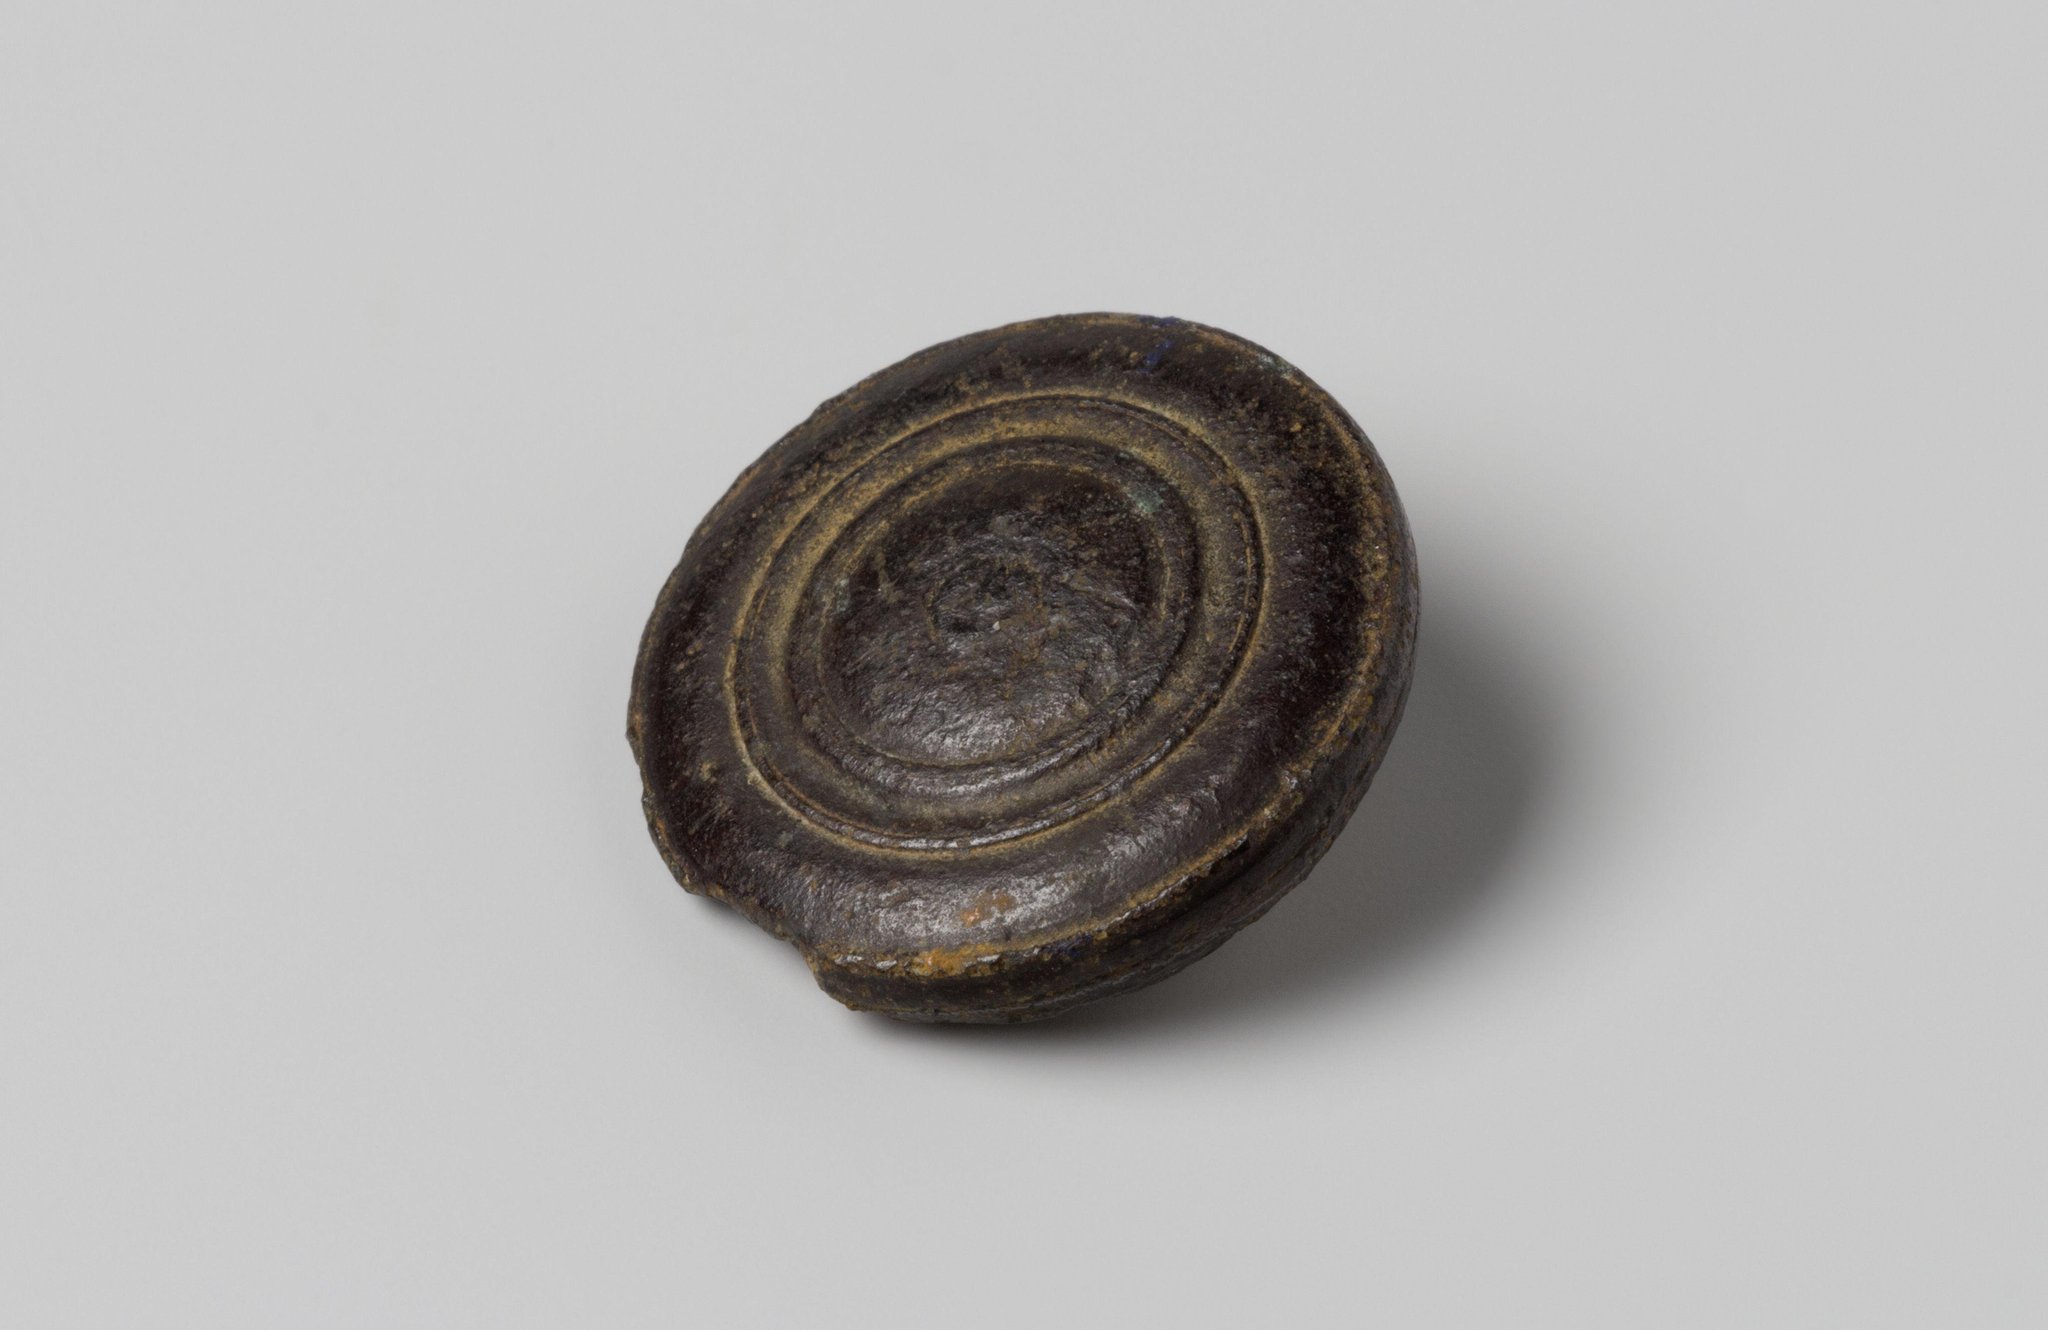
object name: button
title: Knoop uit het wrak van de Oost-Indiëvaarder Hollandia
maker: Anonymous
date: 1700-1743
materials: copper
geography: netherlands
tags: verenigde oostindische compagnie, hollandia (schip), annet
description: Knoop, met afgebroken fragment. (1) fragm, flat top, concentric moulding (2.4d, 0.5t), filled with wood